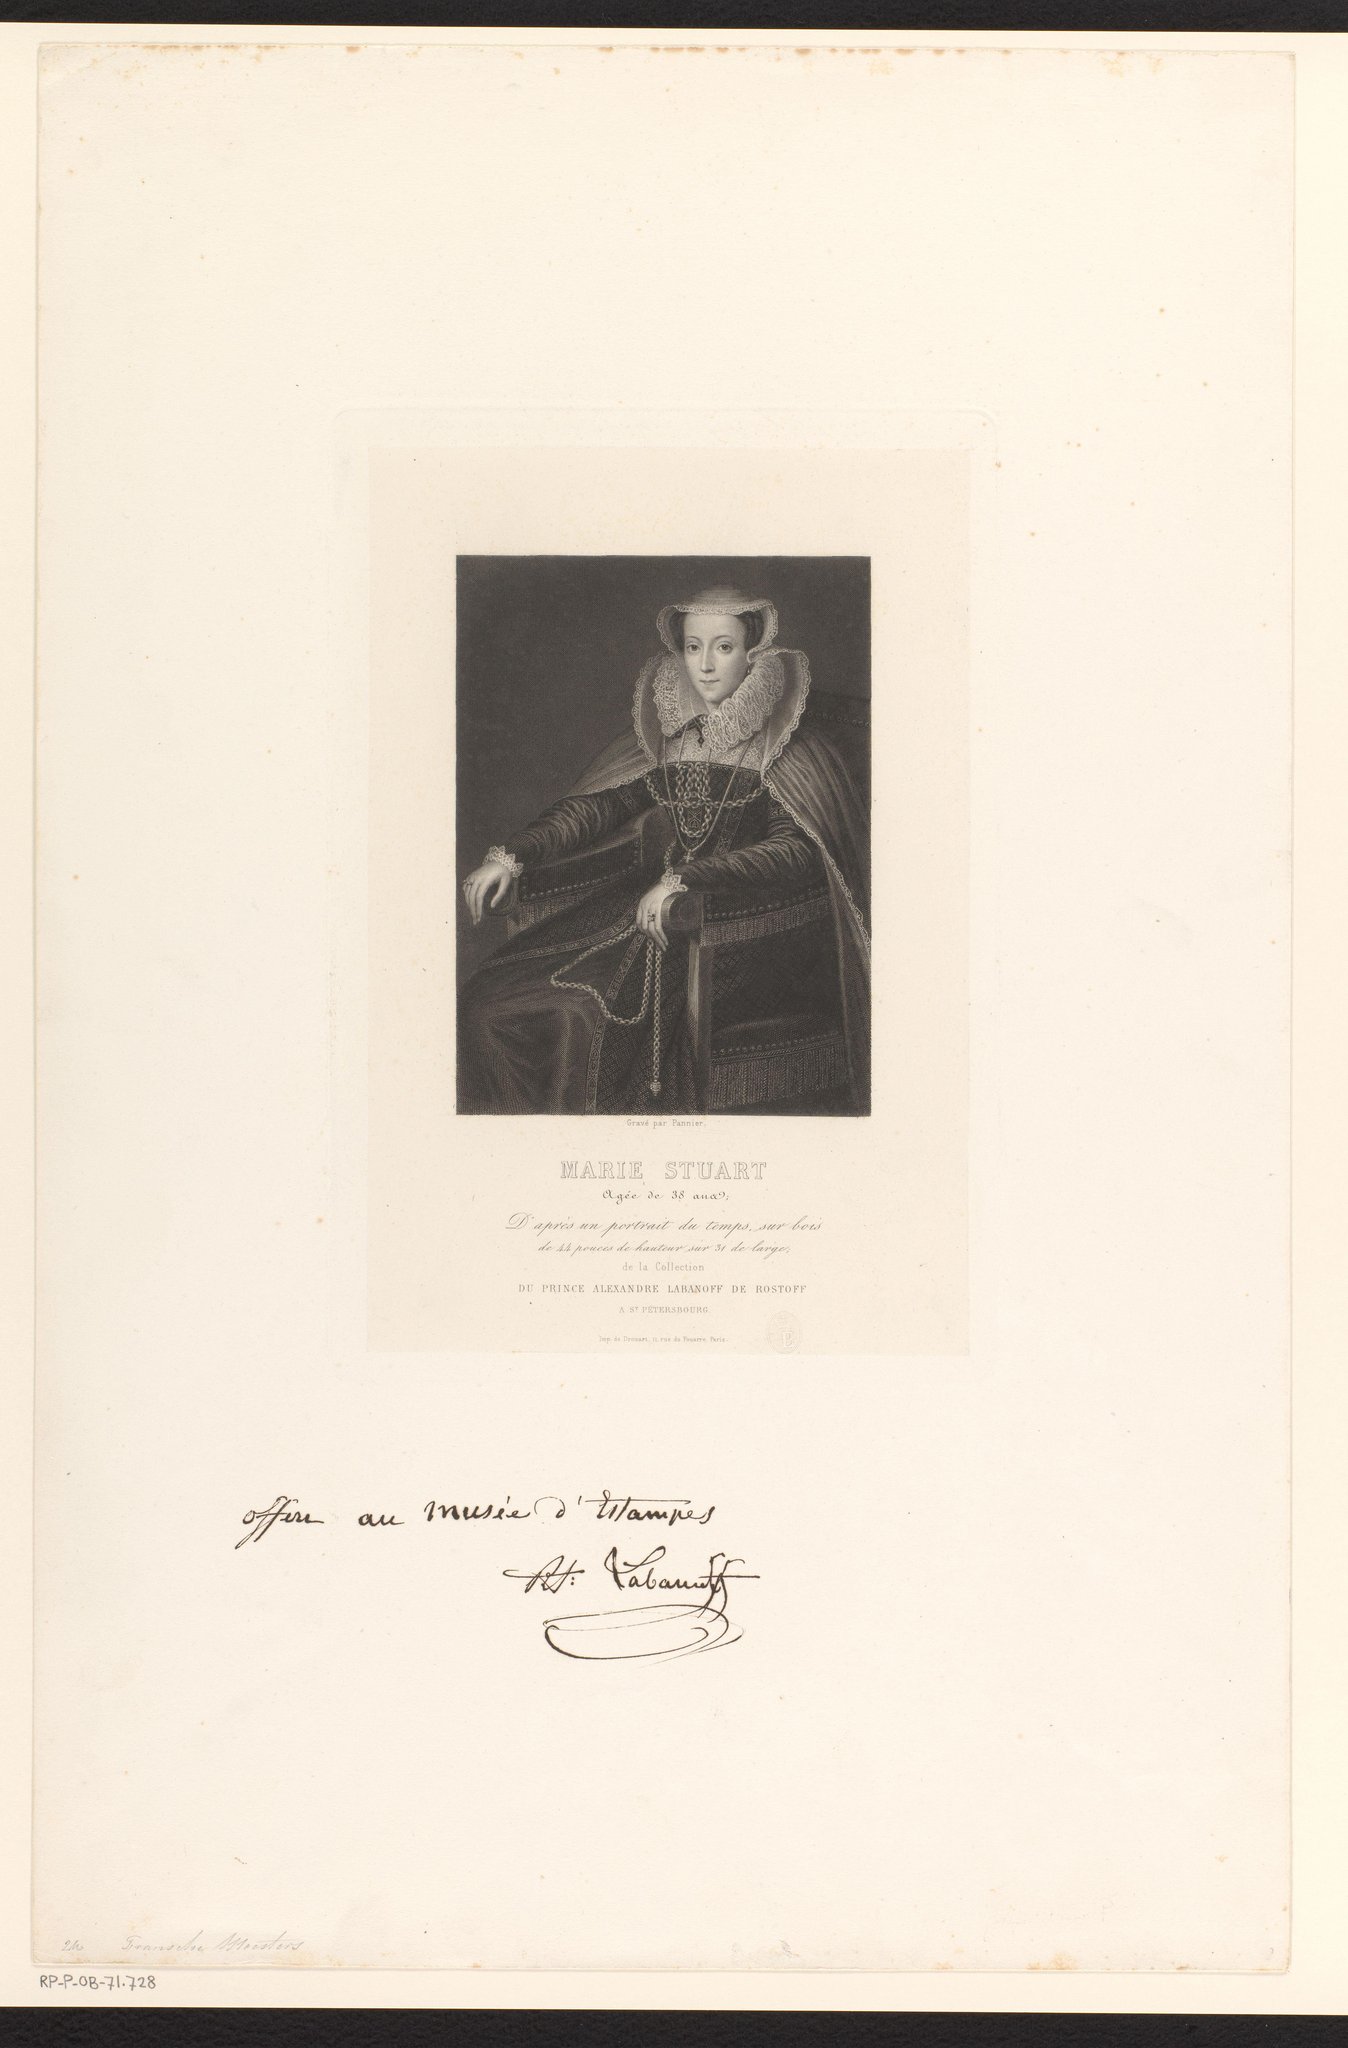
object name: print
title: Marie Stuart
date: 1860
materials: paper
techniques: engraving, etching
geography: paris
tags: historical persons - bb - woman, queen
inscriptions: collector's mark: Lugt 1654, annotation: ‘offere au Musée d'Estampes A.Y. Labanoff’, check stamp: Lugt 142, collector's mark: Lugt 12